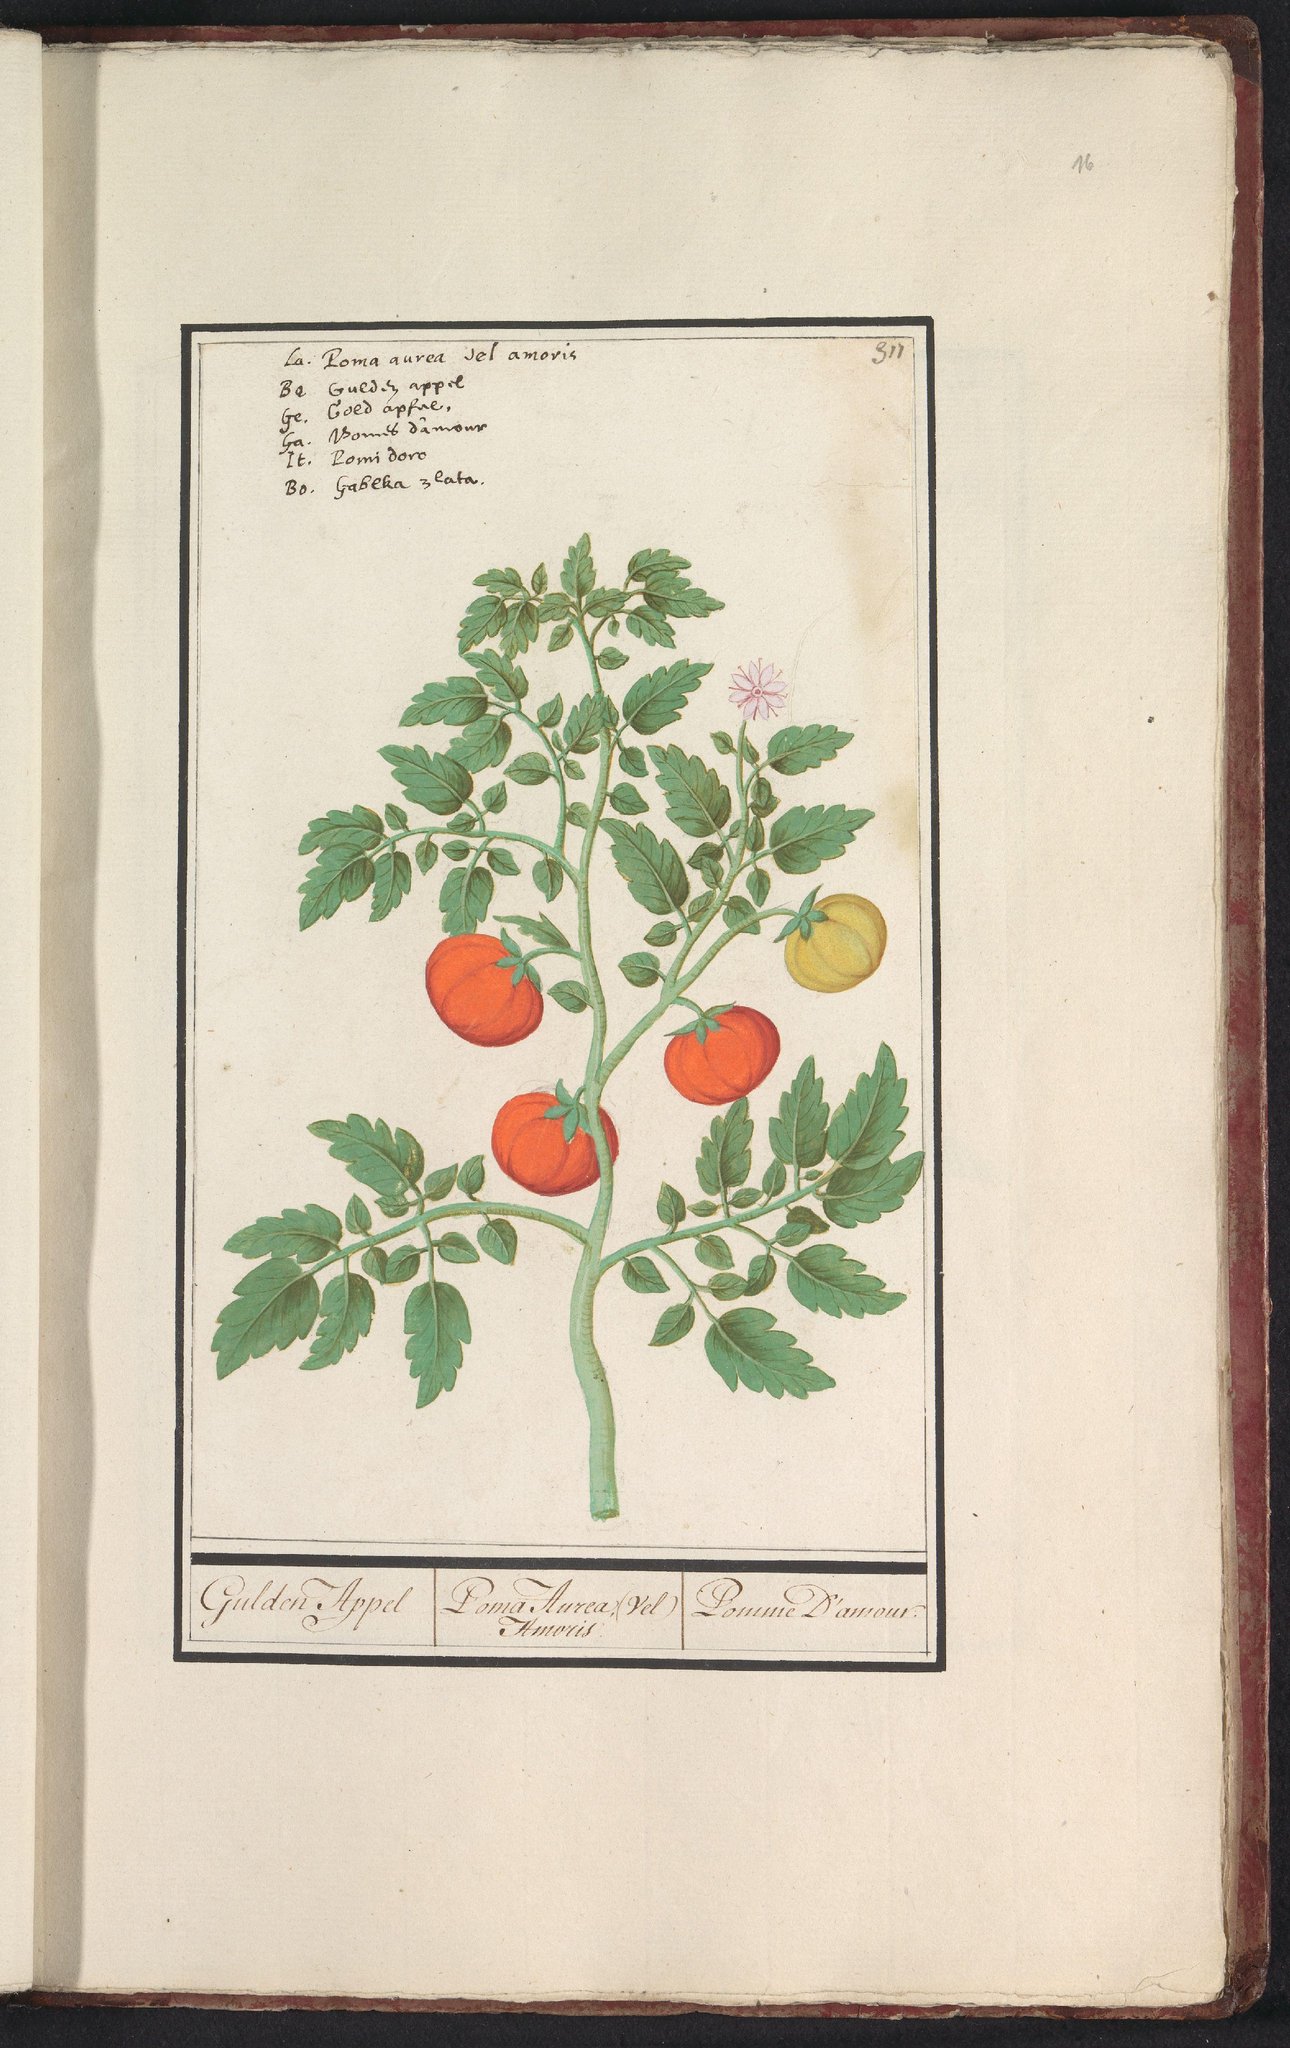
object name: drawing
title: Gulden Appel / Poma Aurea (Vel) Amoris / Pomme D'amour.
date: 1596-1610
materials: chalk, paint, ink, paper, watercolor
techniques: brush, pen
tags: vegetables (with name)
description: Tomaat. Genummerd rechtsboven: 311. Linksboven de naam in zes talen. Onderdeel van het vierde album met tekeningen van bloemen en paddestoelen. Elfde van twaalf albums met tekeningen van dieren, vogels en planten bekend rond 1600, gemaakt in opdracht van keizer Rudolf II. Met toelichting in Nederlands, Latijn en Frans.